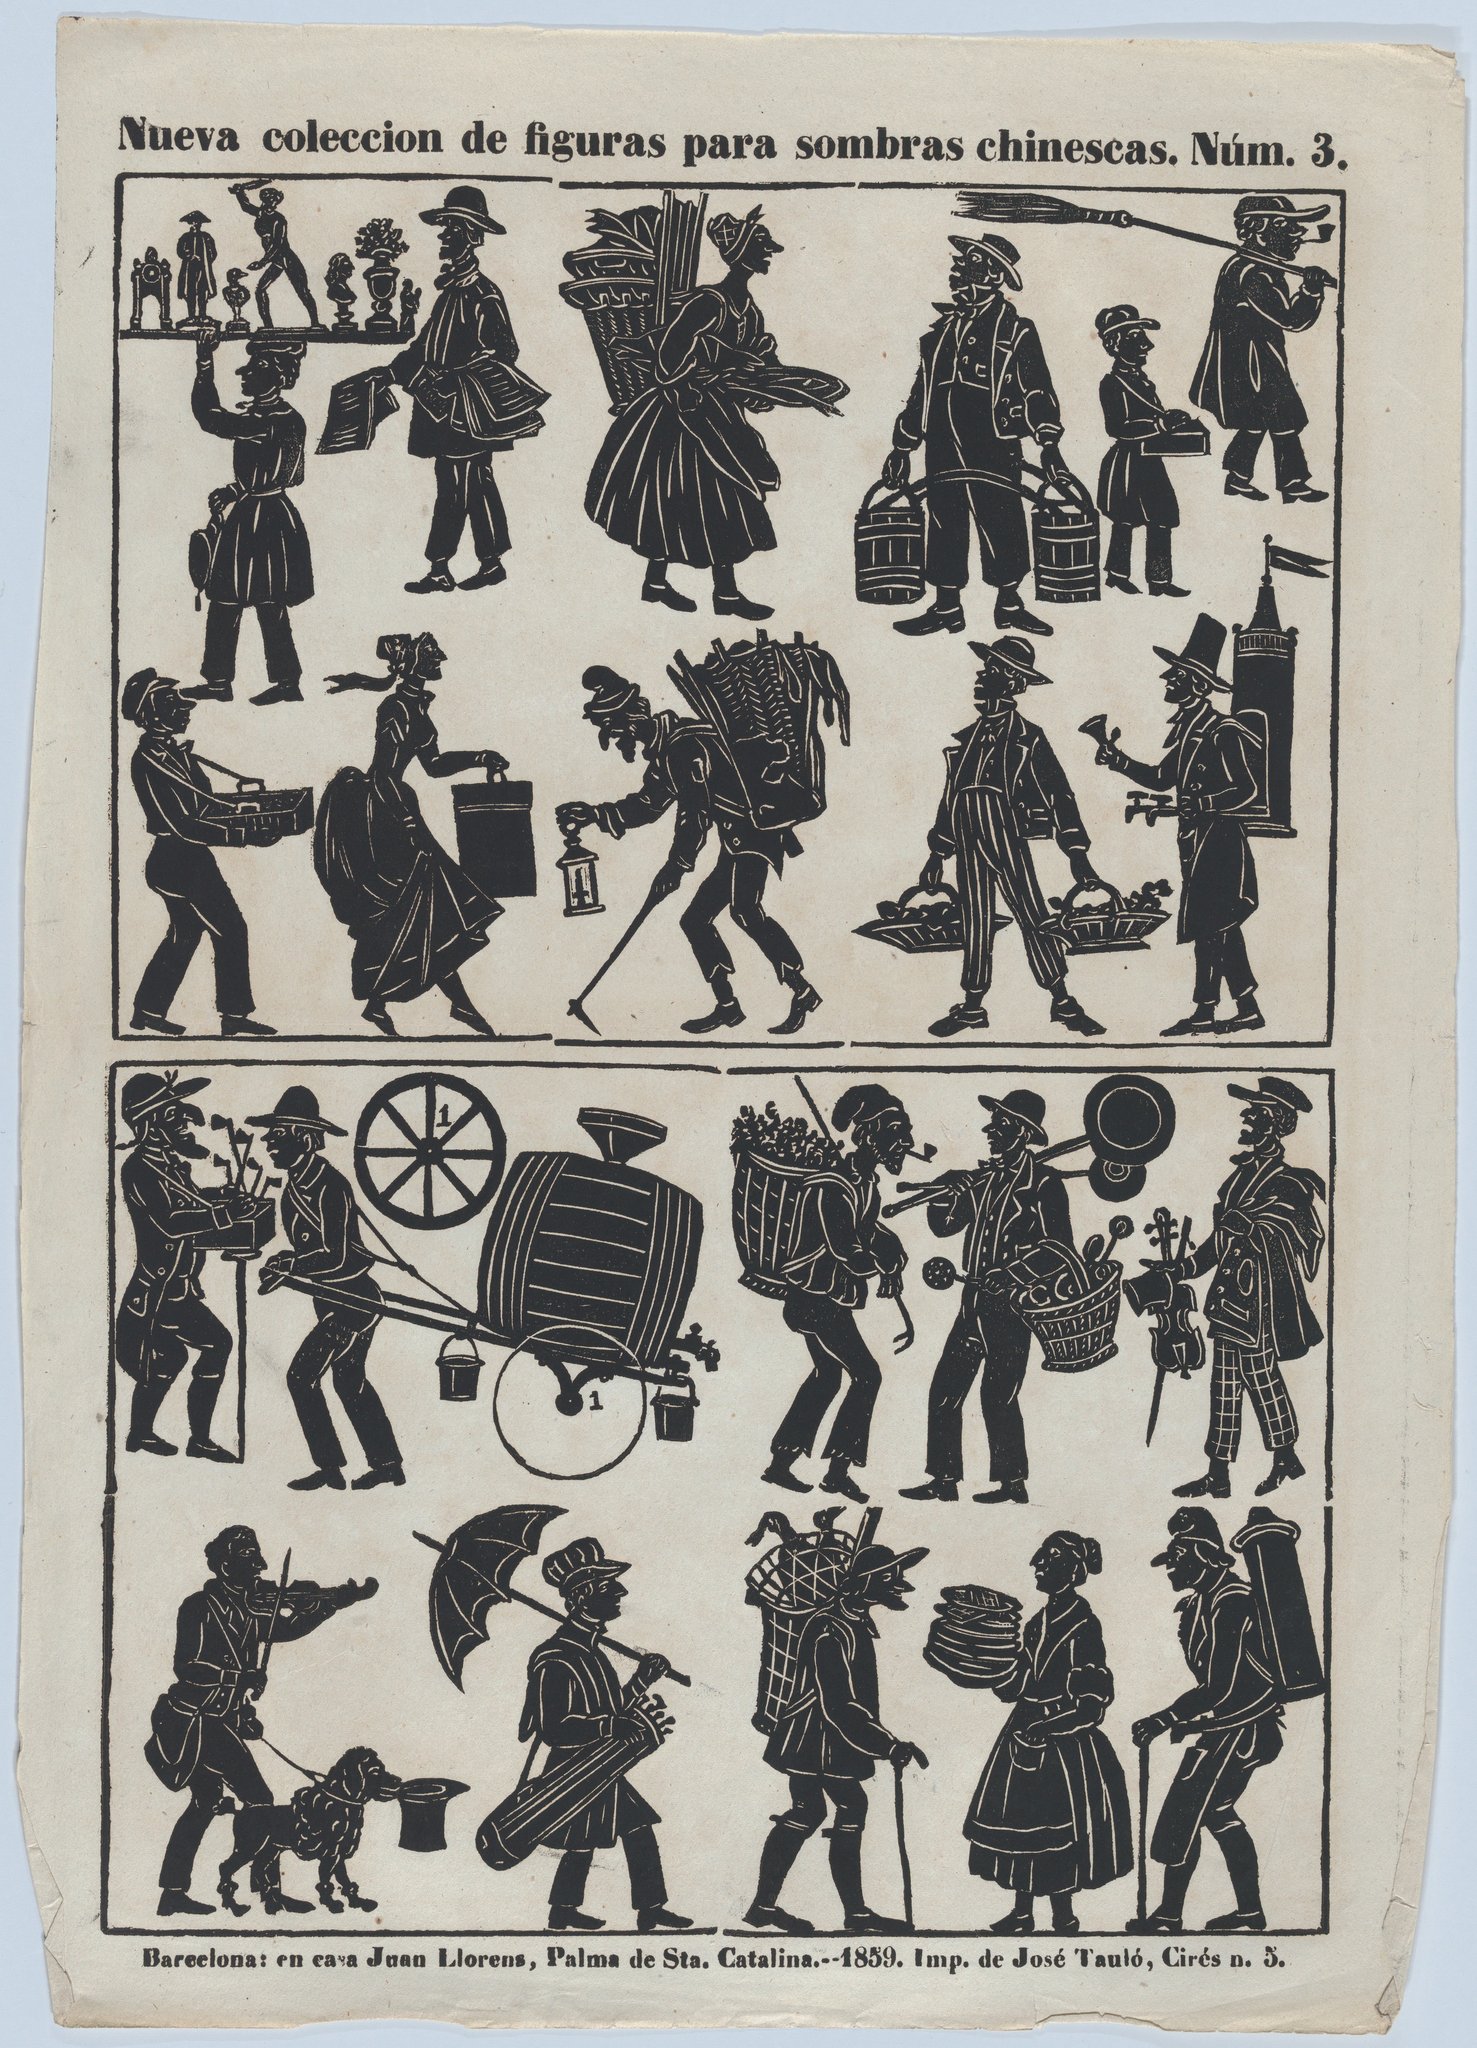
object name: print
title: Sheet 3 of figures for Chinese shadow puppets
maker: juan llorens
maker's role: publisher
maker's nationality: spanish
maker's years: 1800-1900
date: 1859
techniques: engraving, woodcut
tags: men,women,puppets